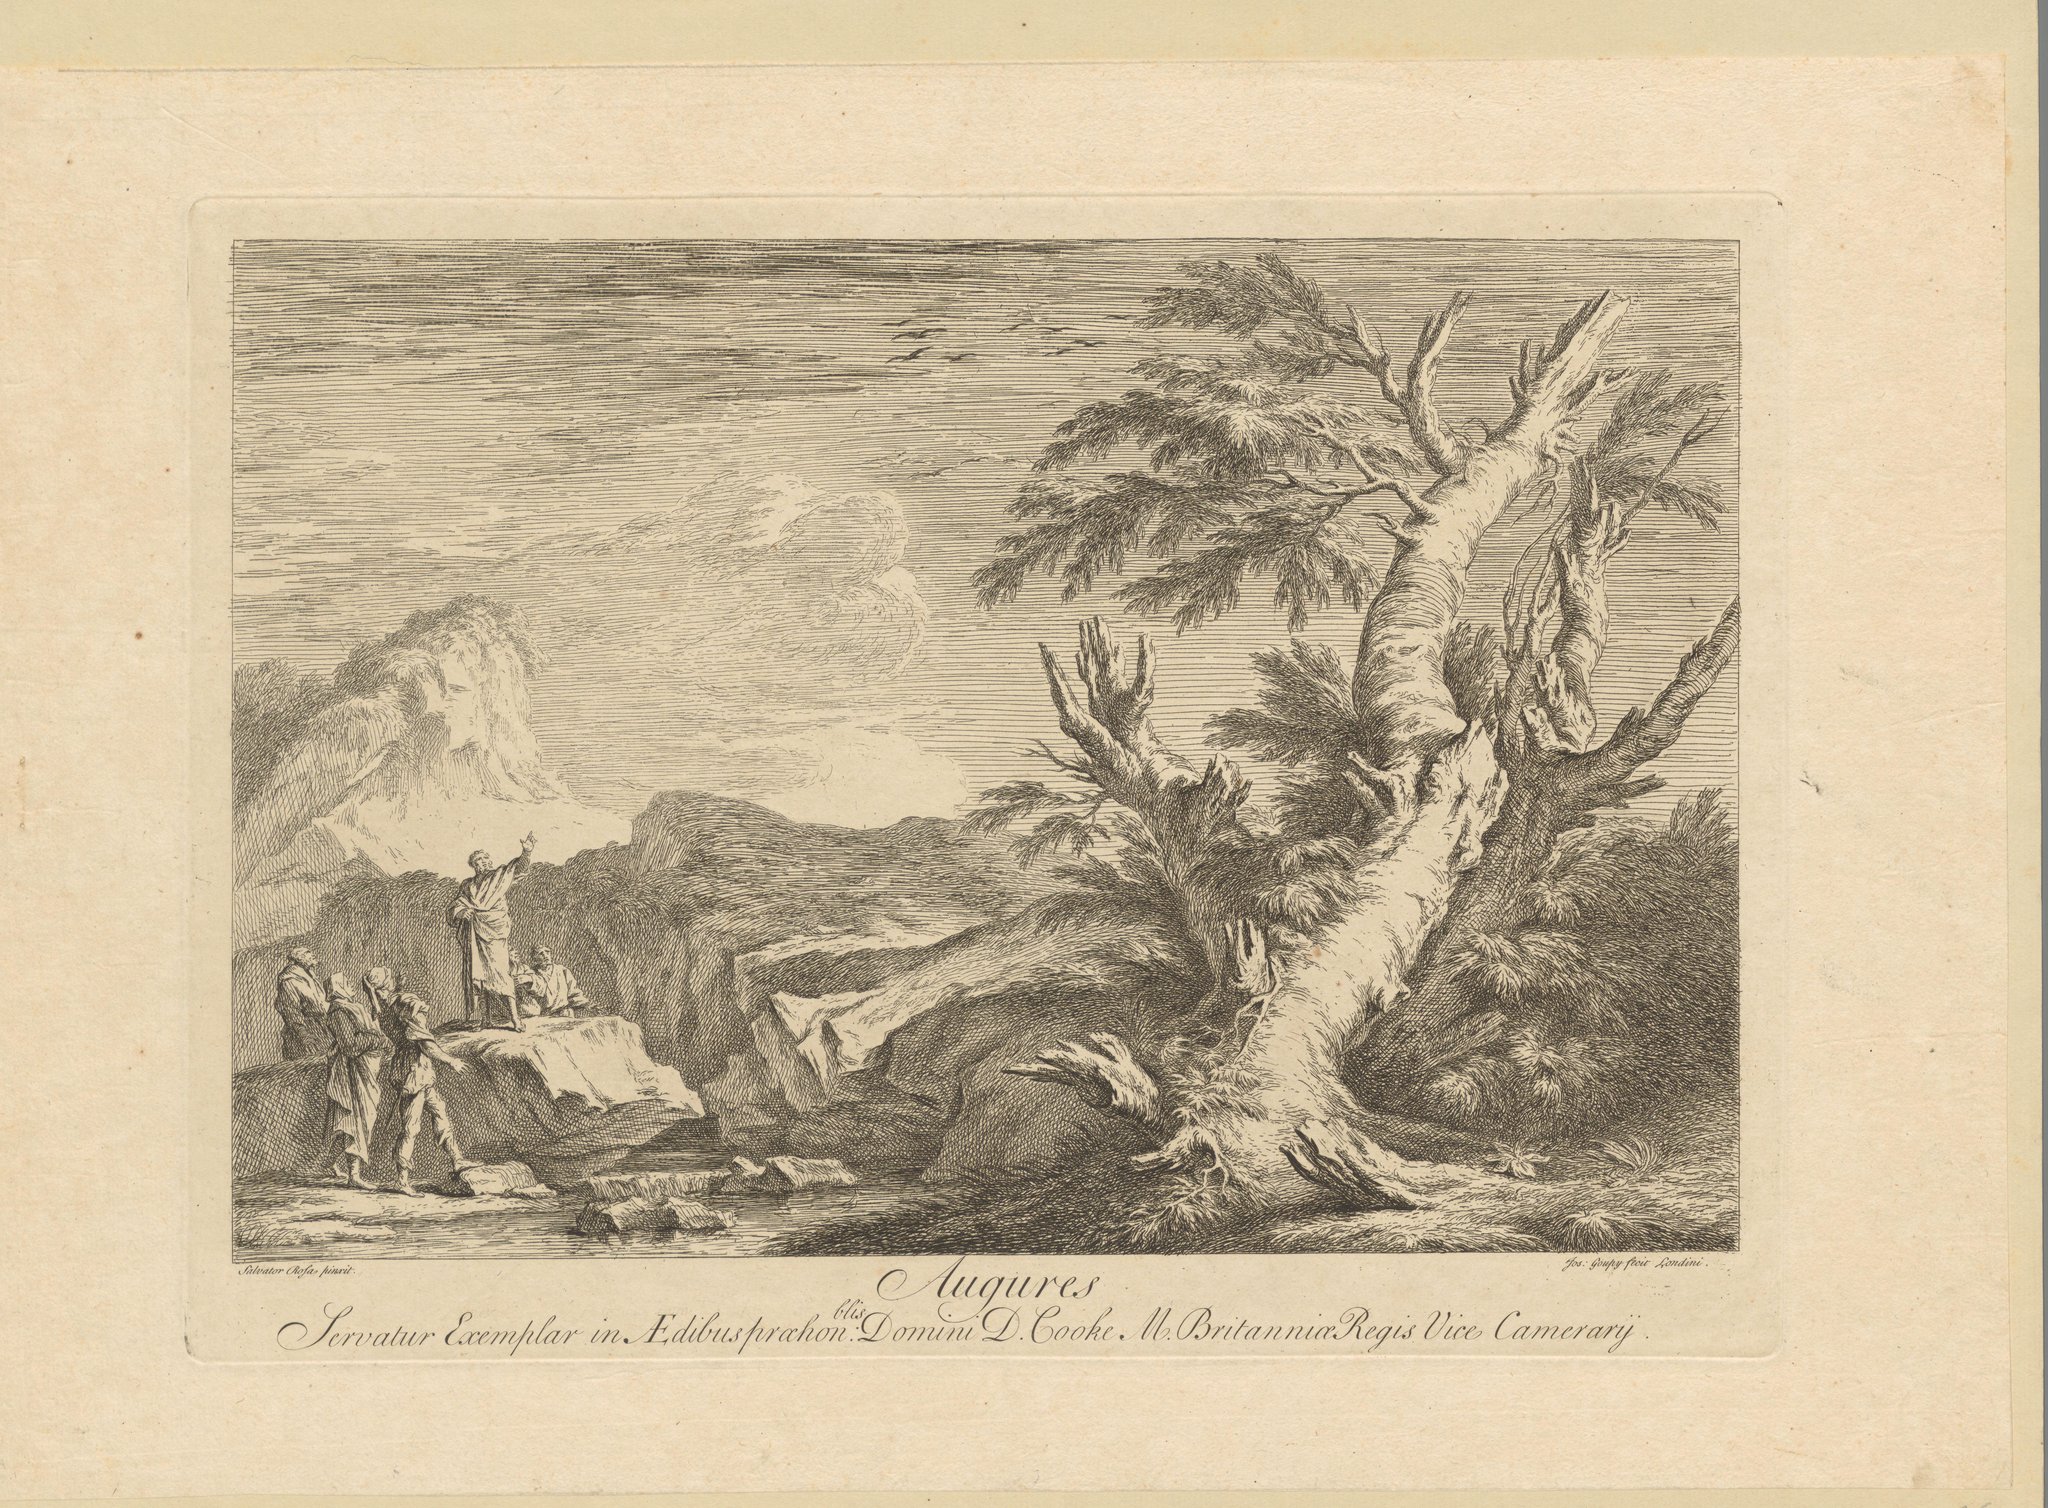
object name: print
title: Landschap met een gevelde boom en auguren die op een rots naar de lucht kijken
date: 1680-1747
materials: paper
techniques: etching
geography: london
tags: trees, 'augur' ~ roman religion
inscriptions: collector's mark: Lugt 240